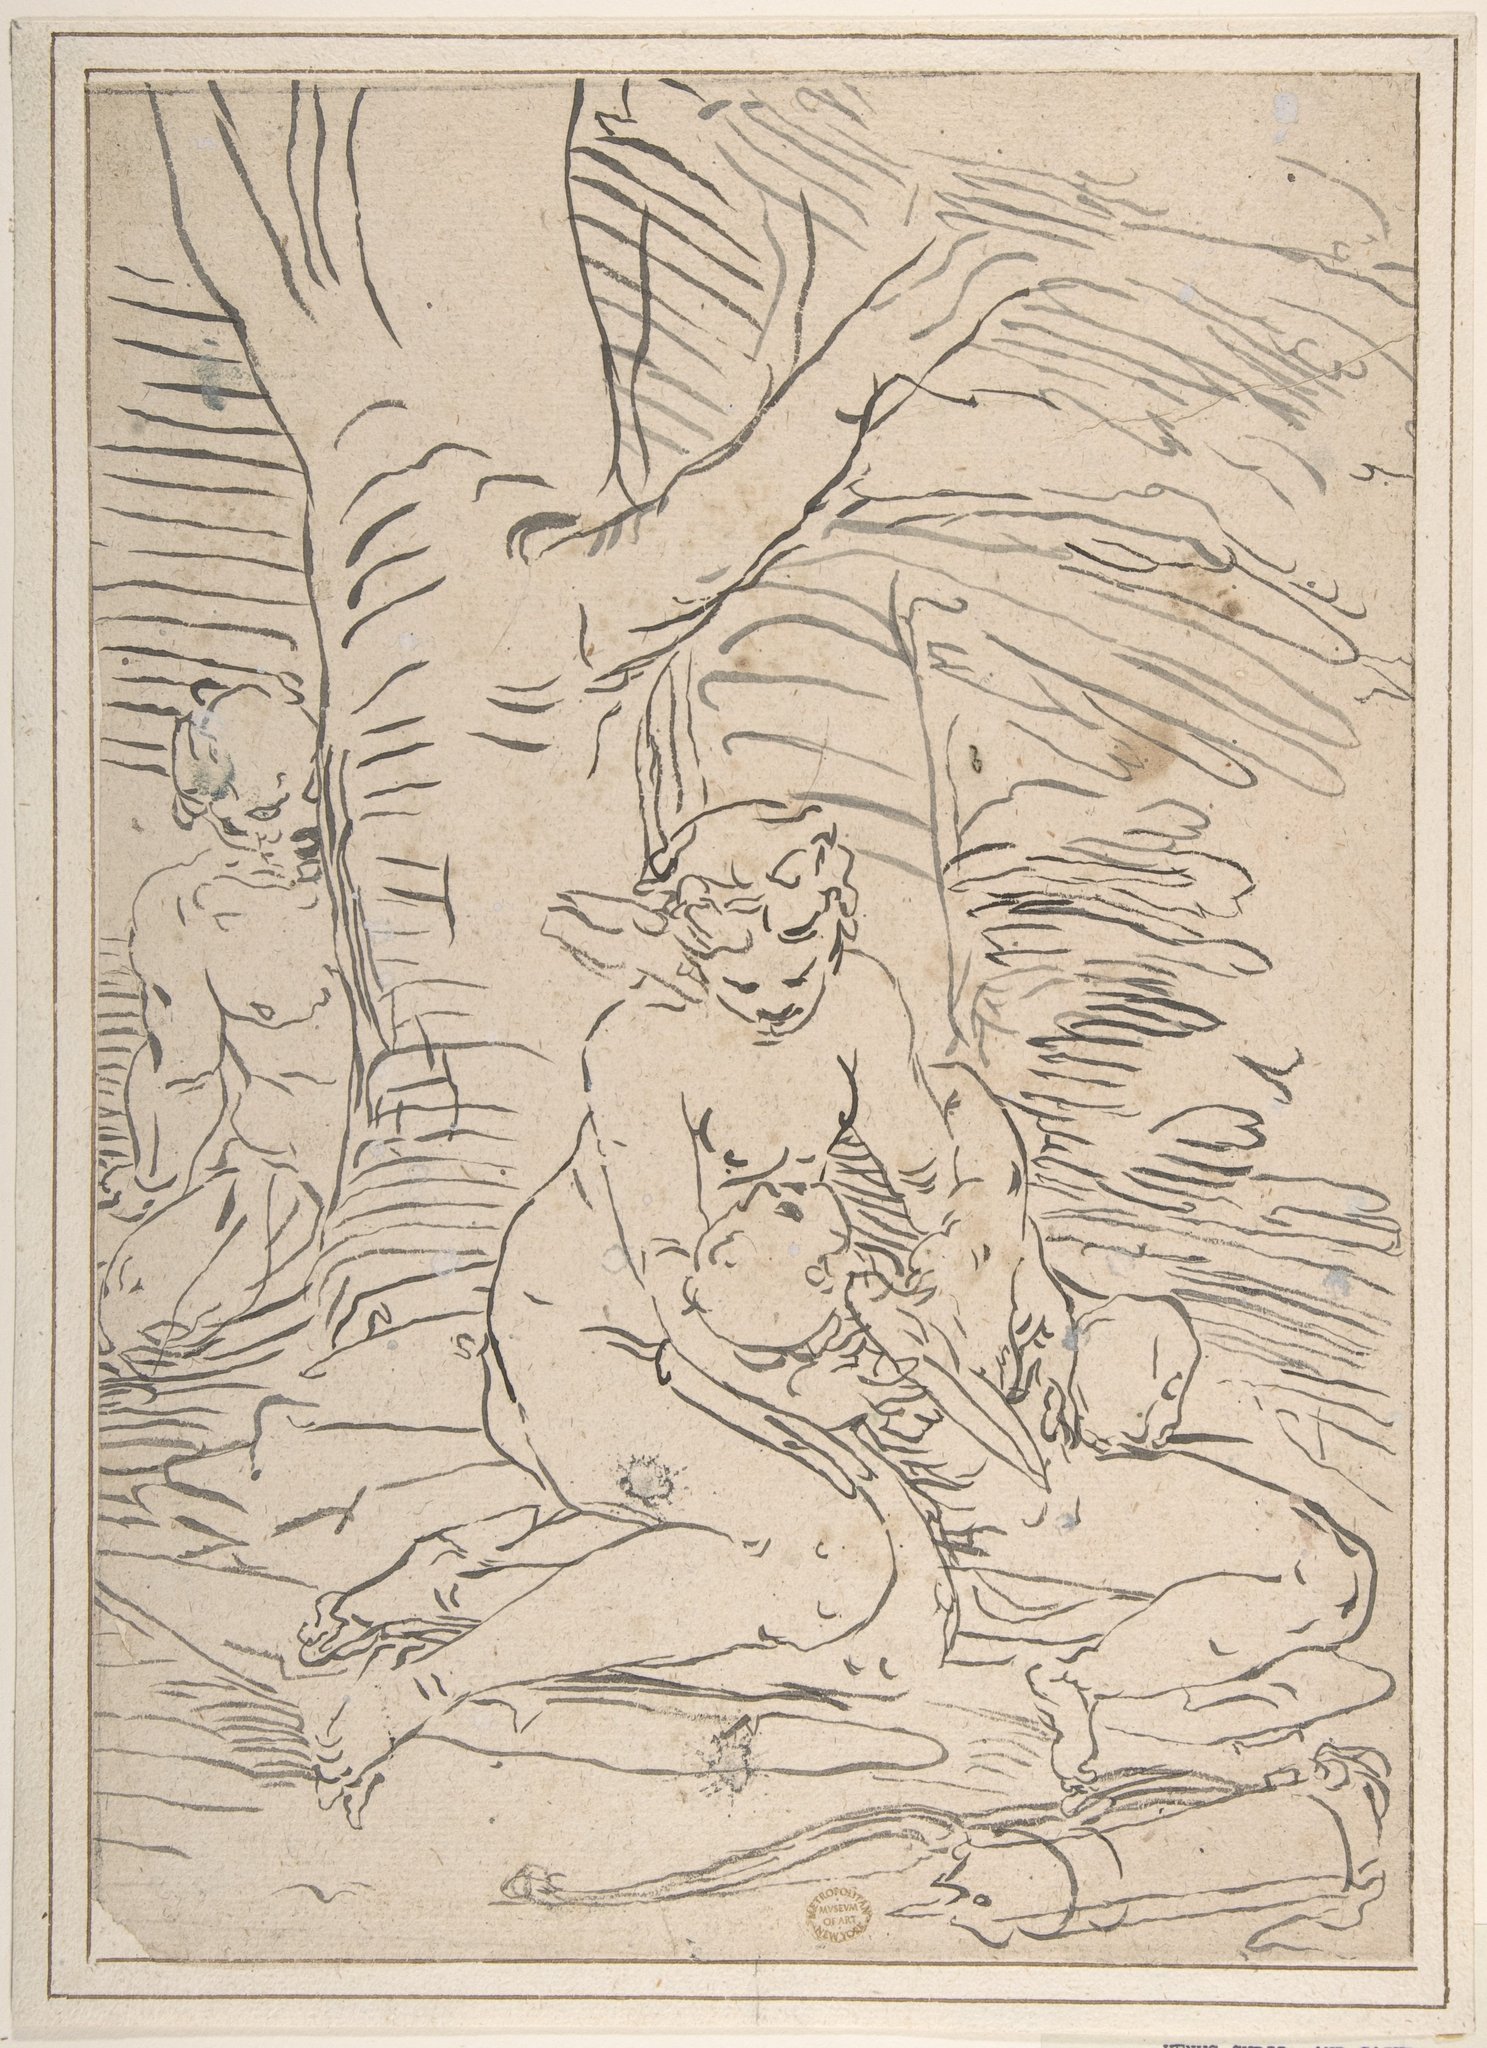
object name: drawing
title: Venus, Cupid and Satyr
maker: luca cambiaso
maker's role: artist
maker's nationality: italian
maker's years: 1527-1585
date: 1527-1585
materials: ink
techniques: brush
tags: cupid,venus,satyrs